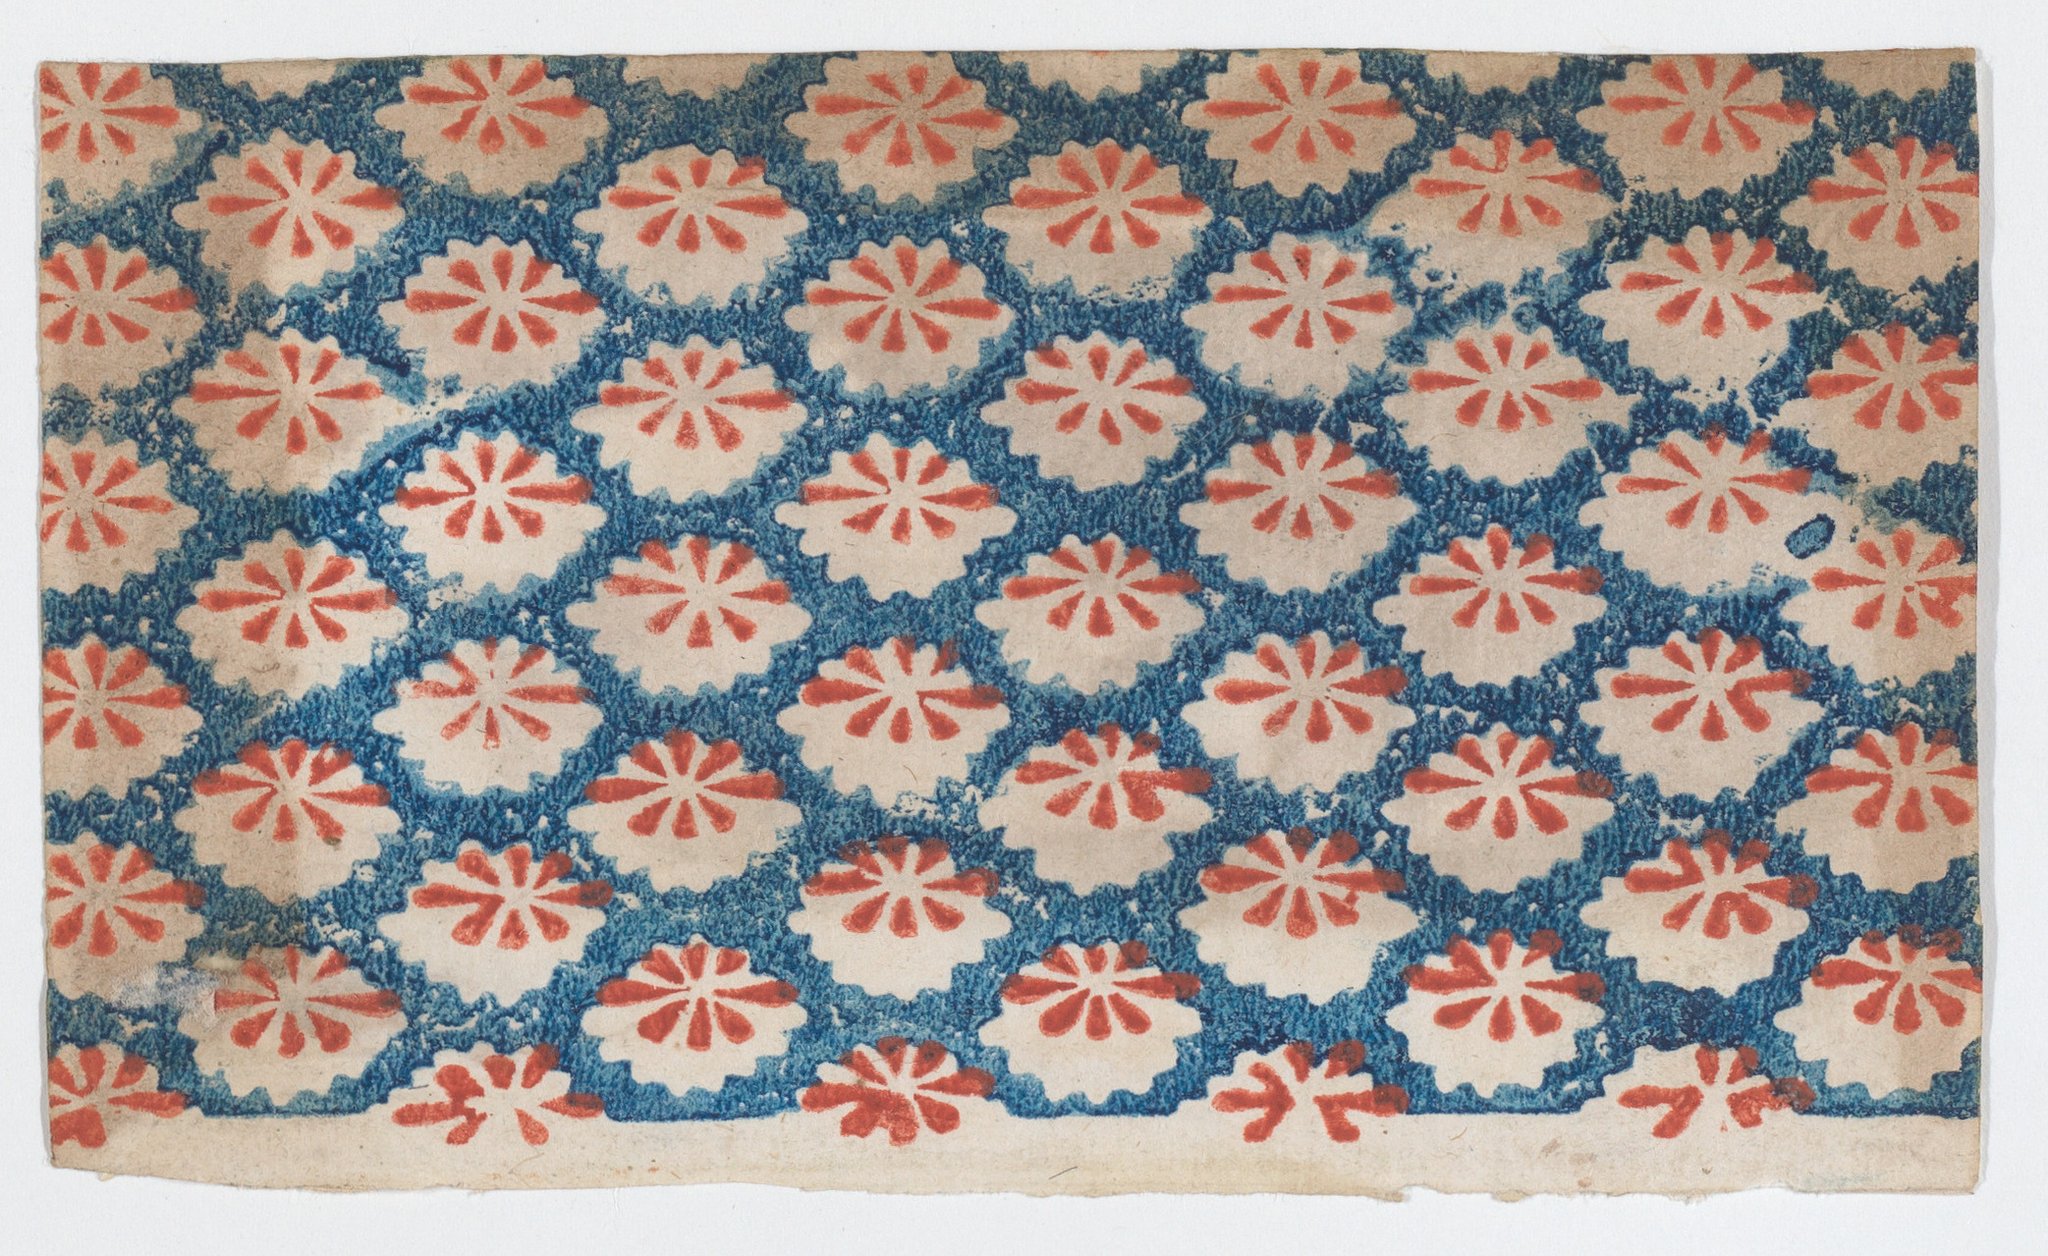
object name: print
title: Sheet with overall pattern of ovals with red designs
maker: Anonymous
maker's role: artist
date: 1801-1900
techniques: relief print